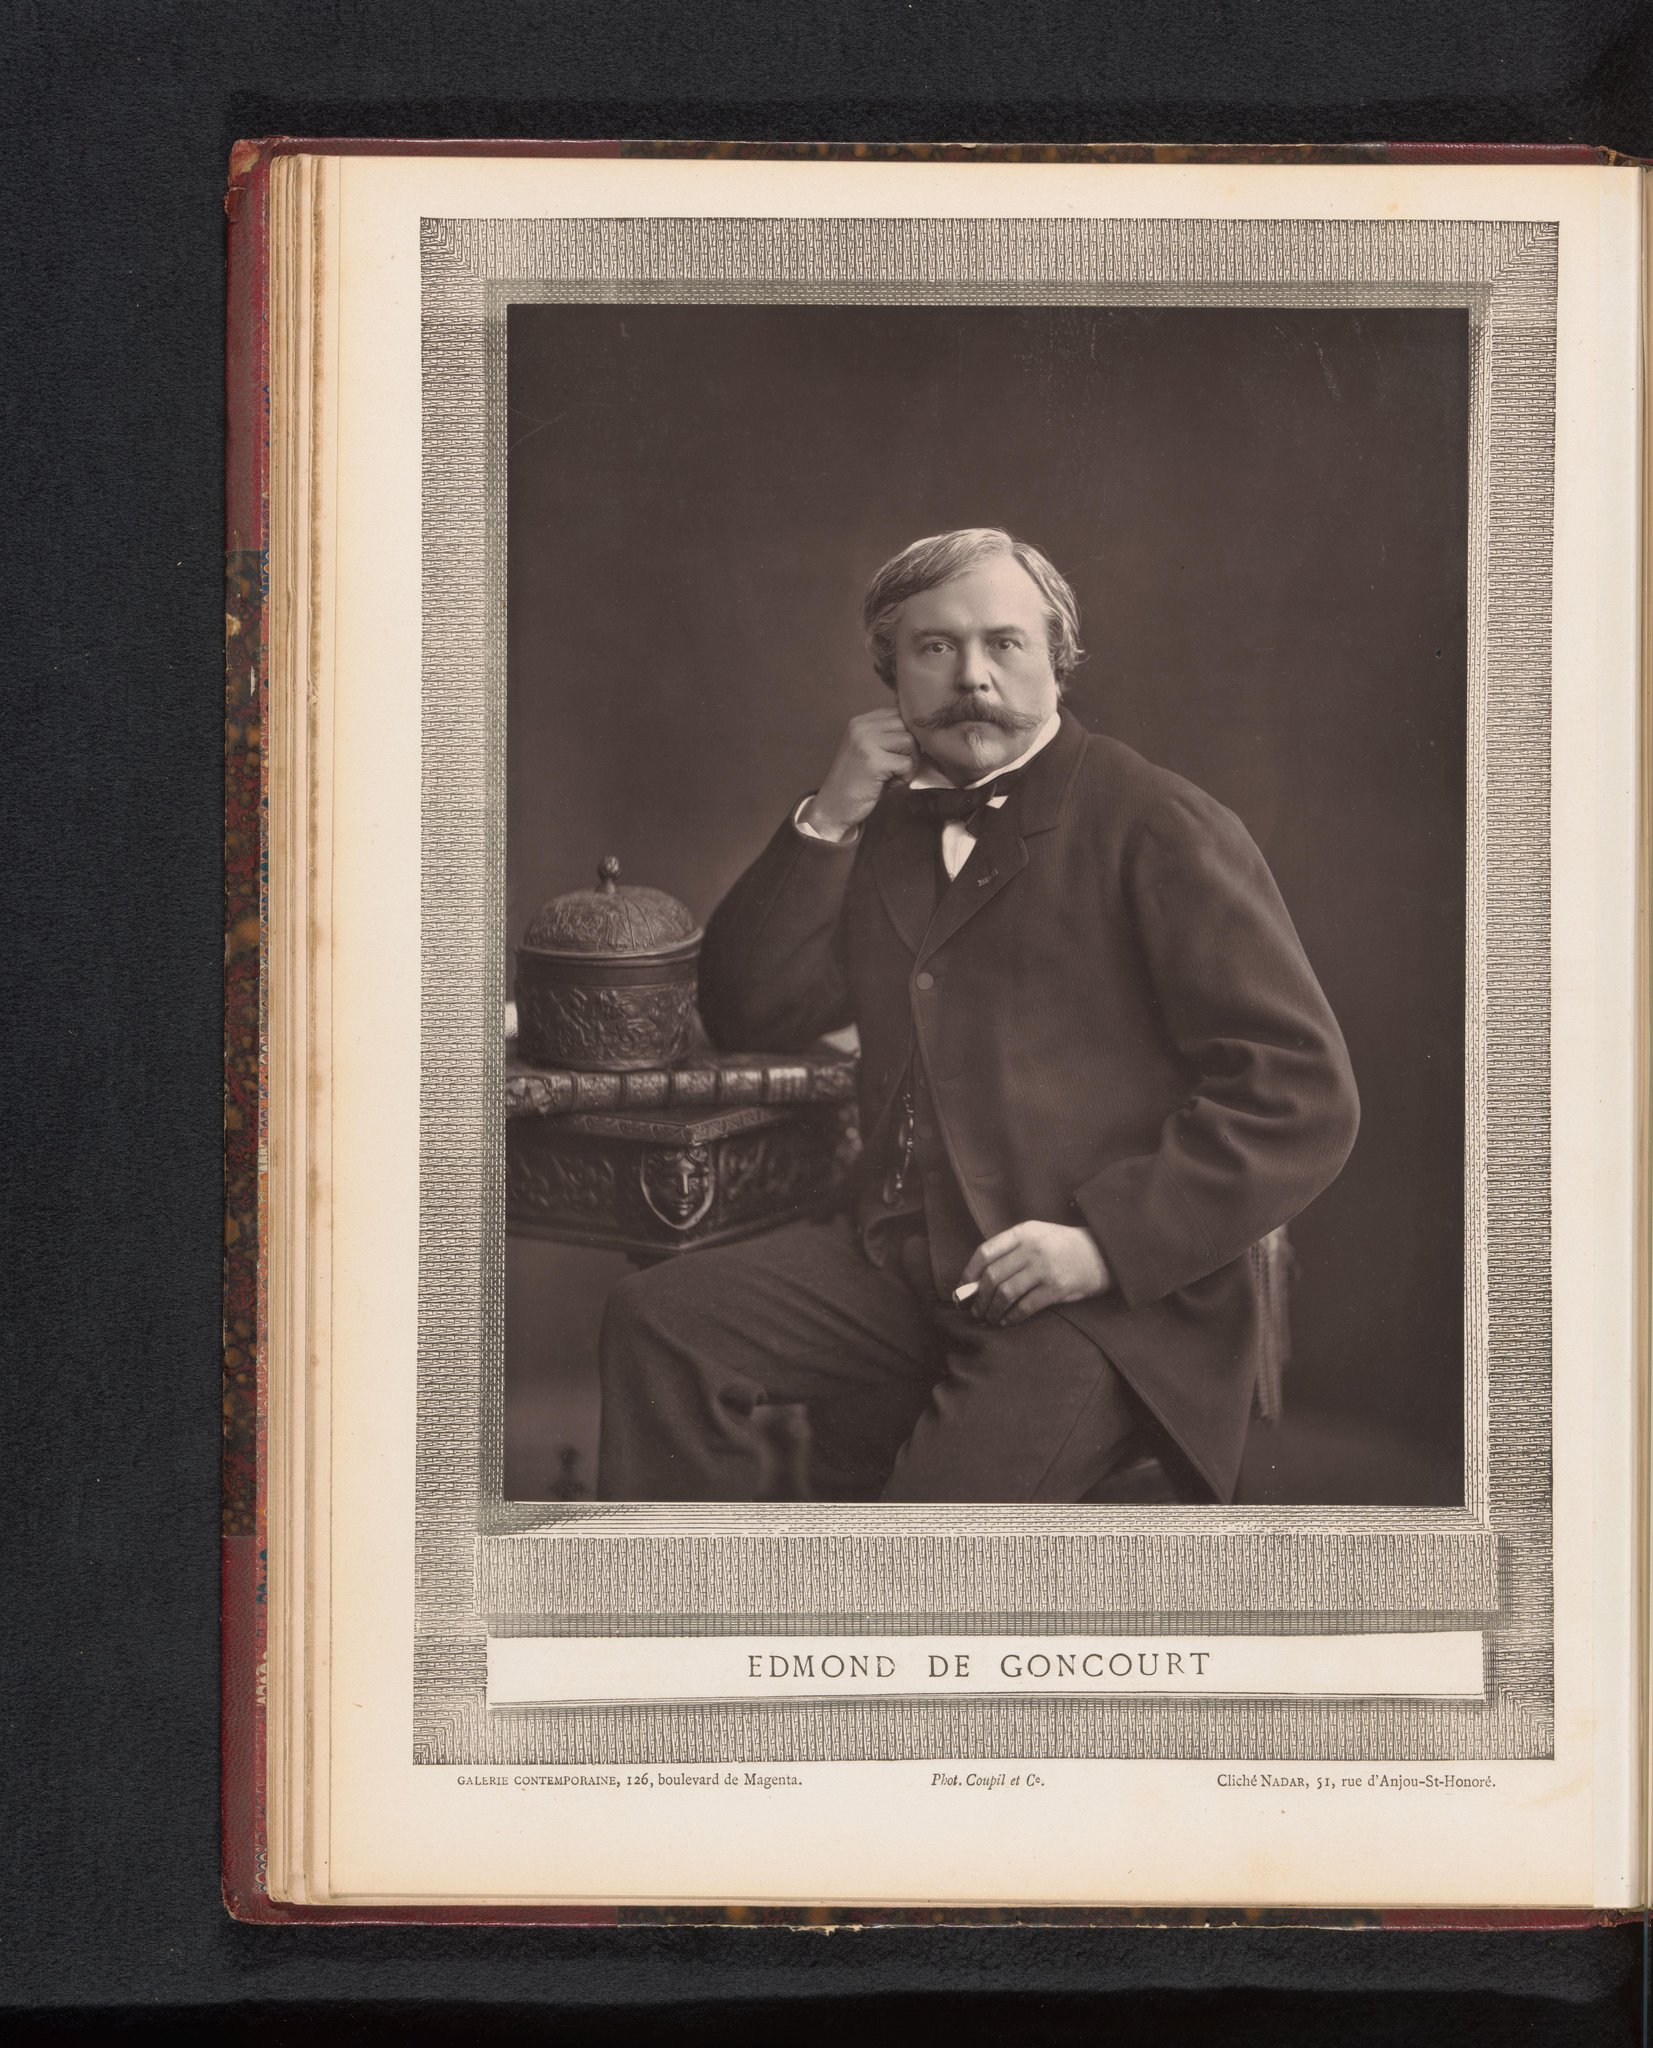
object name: page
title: Edmond de Goncourt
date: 1872-1877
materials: paper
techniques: printing block, woodburytype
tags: painter, edmond de goncourt, adult man, historical persons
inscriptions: inscription: ‘Galerie Contemporaine, 126, boulevard de Magenta.’